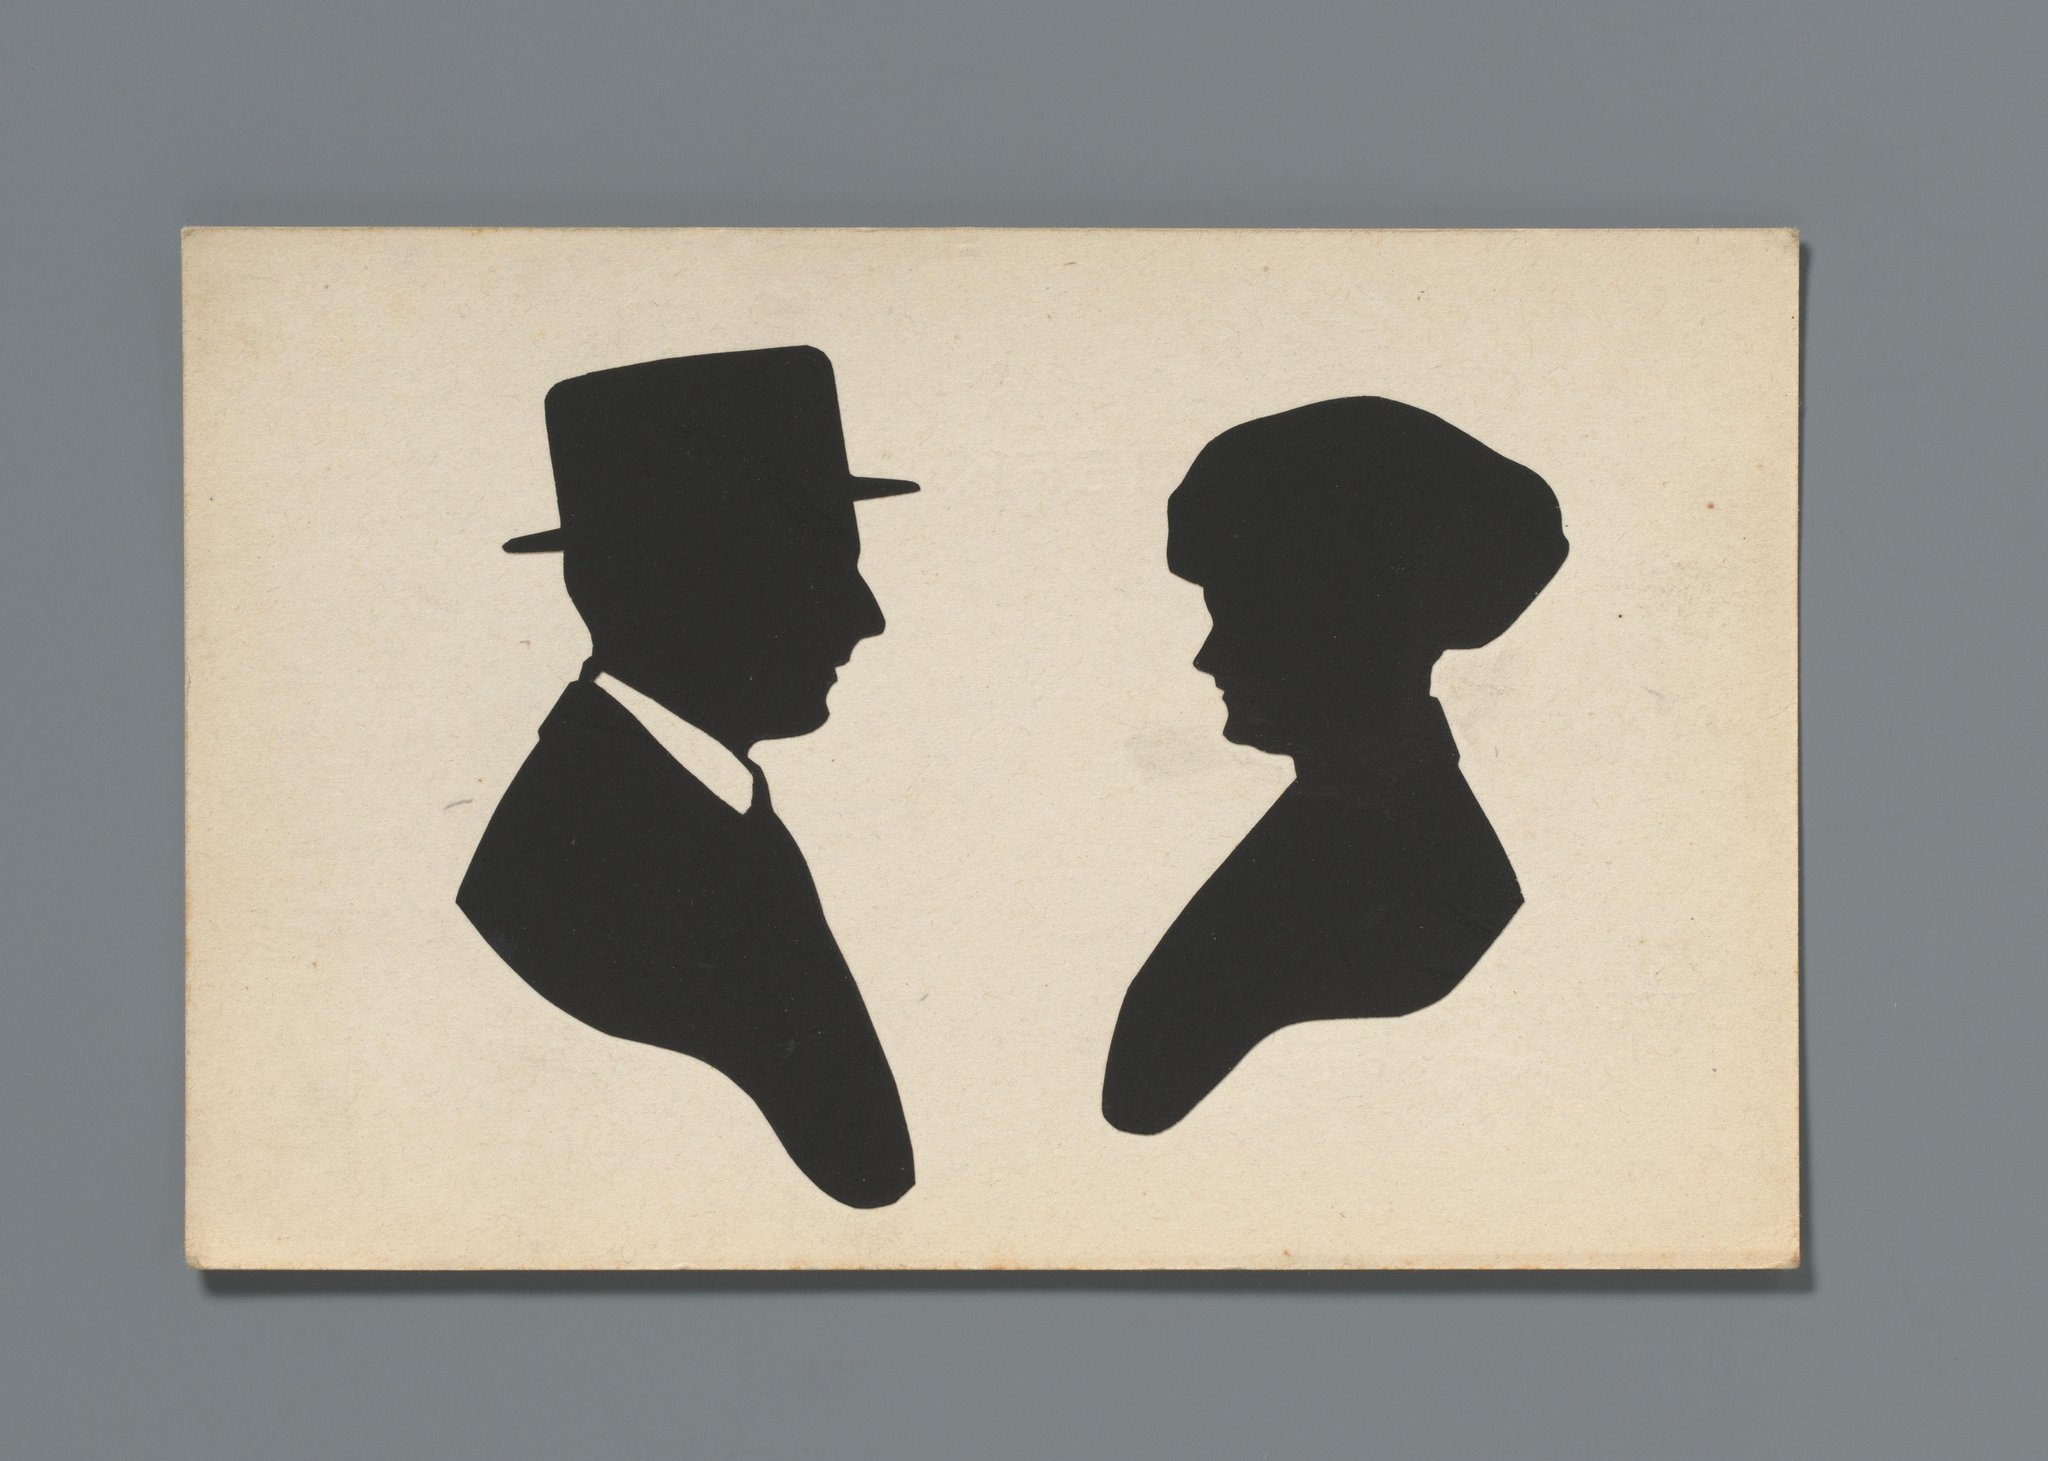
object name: ansichtkaart, prentbriefkaart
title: Souvenir Westerbouwing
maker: Anonymous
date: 1890-1905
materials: cardboard, paper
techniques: snipping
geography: renkum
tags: adult woman, adult man